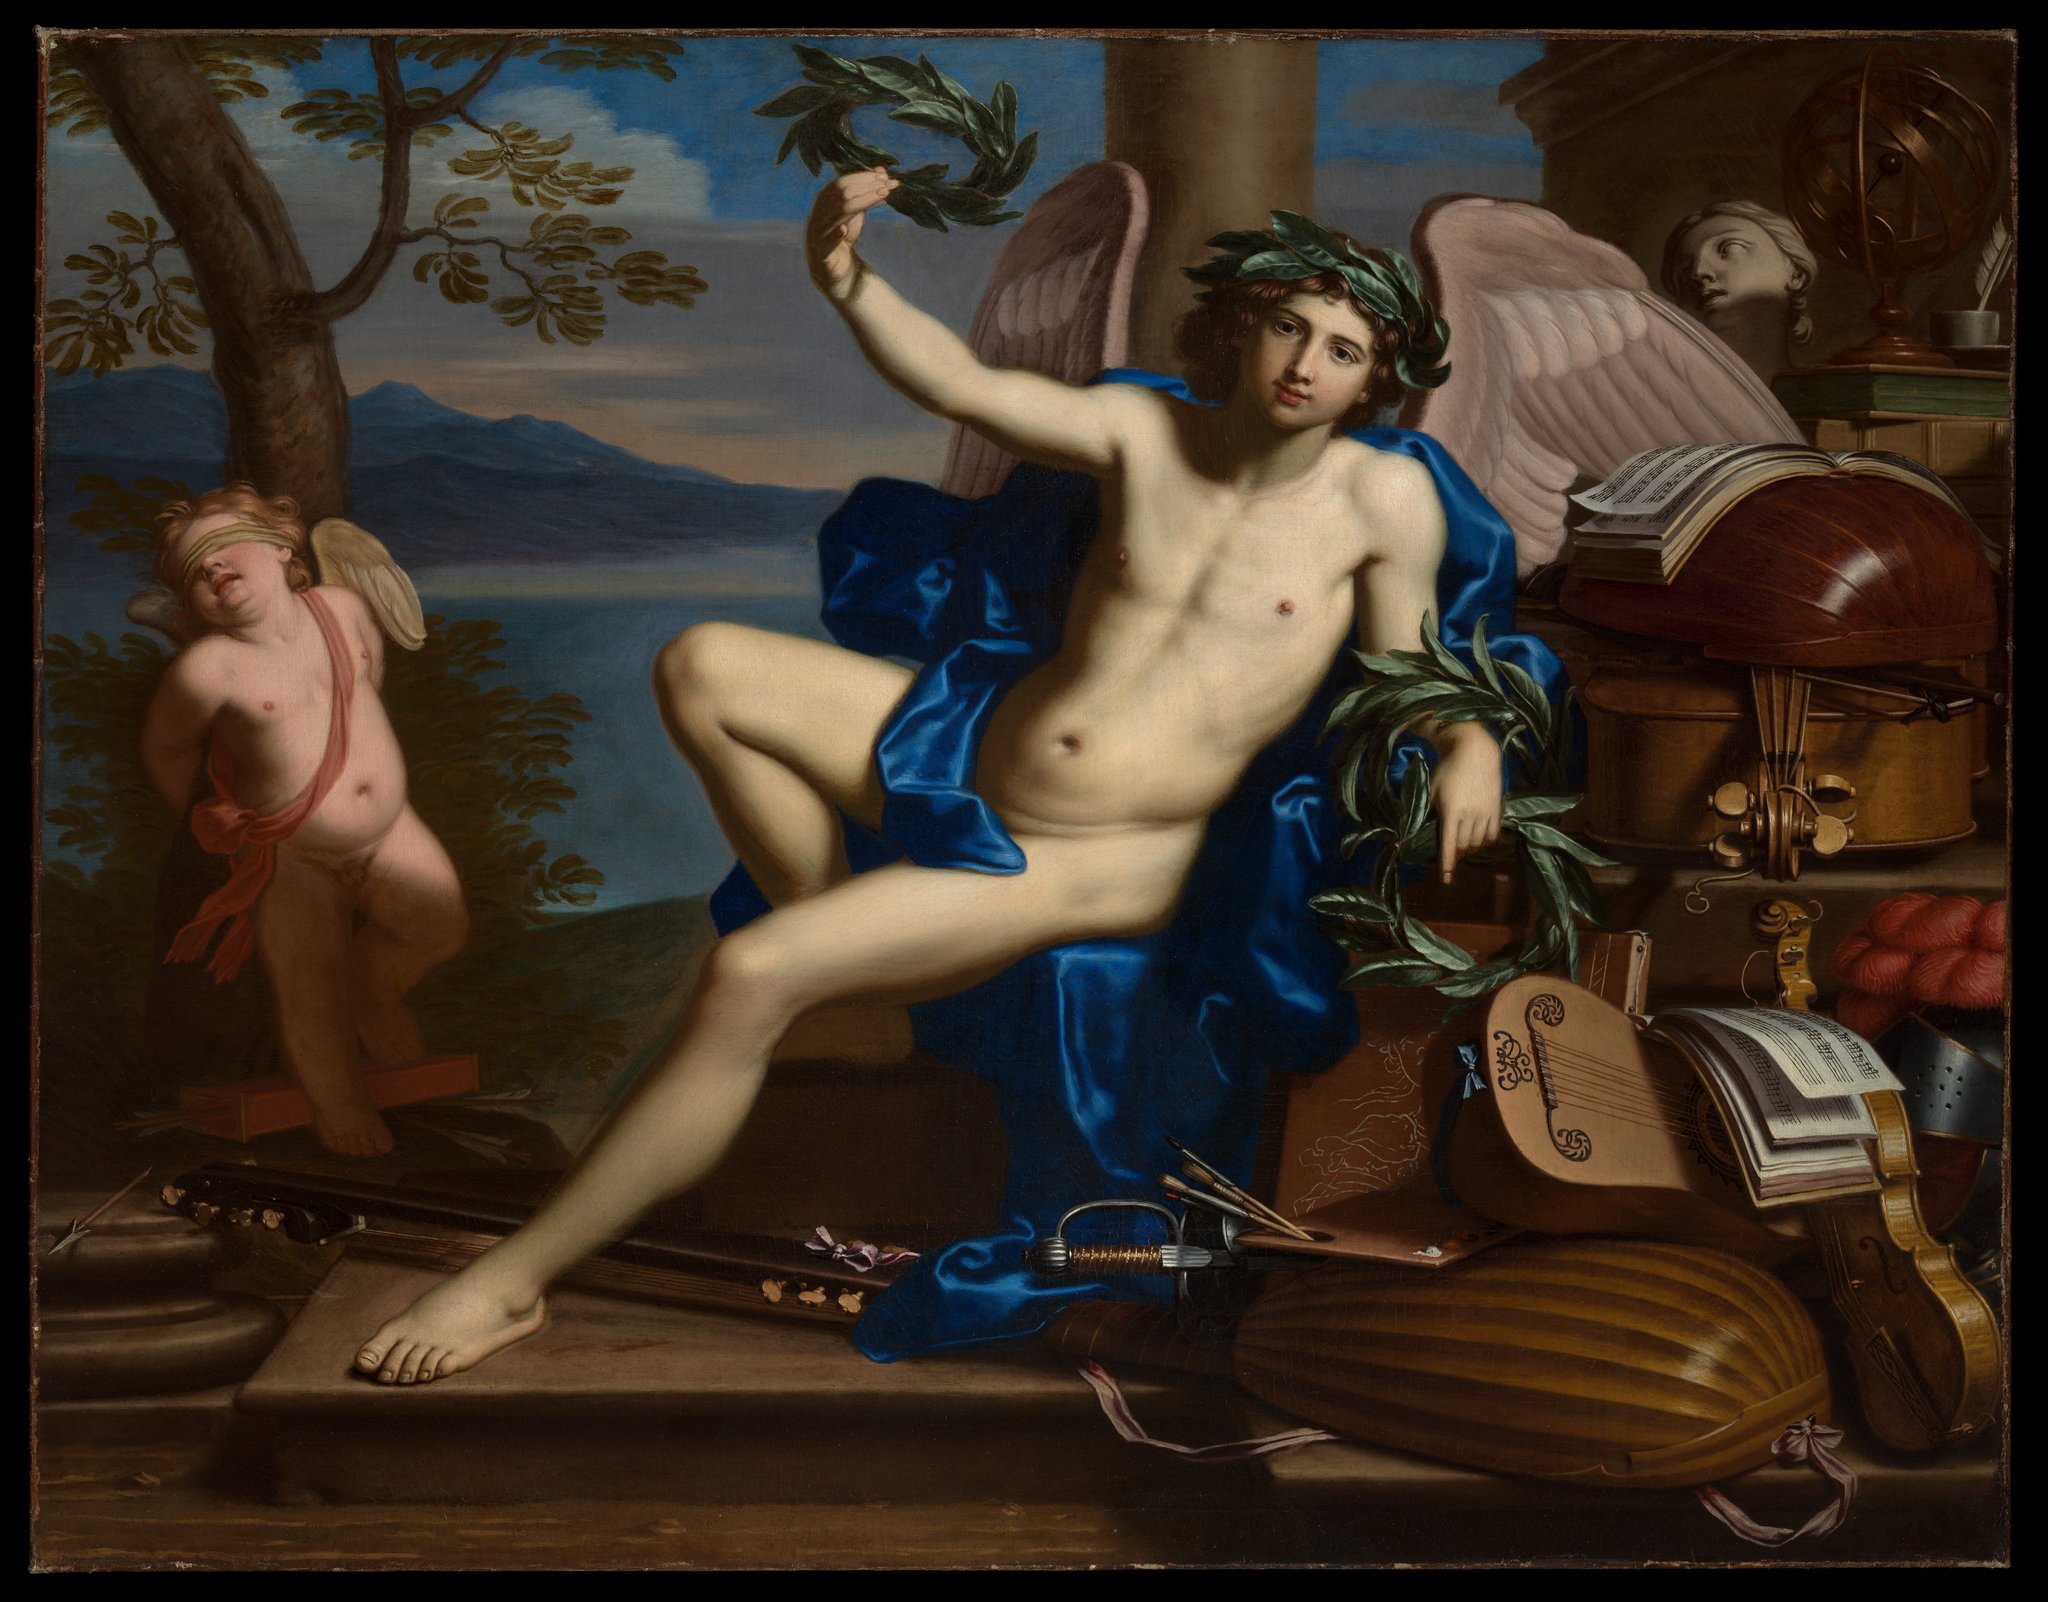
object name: painting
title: Allegory of Sacred and Profane Love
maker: michele desubleo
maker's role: artist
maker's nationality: flemish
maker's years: 1602-1676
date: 1665-1675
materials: canvas, oil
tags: musical instruments,men,lutes,cupid,allegory